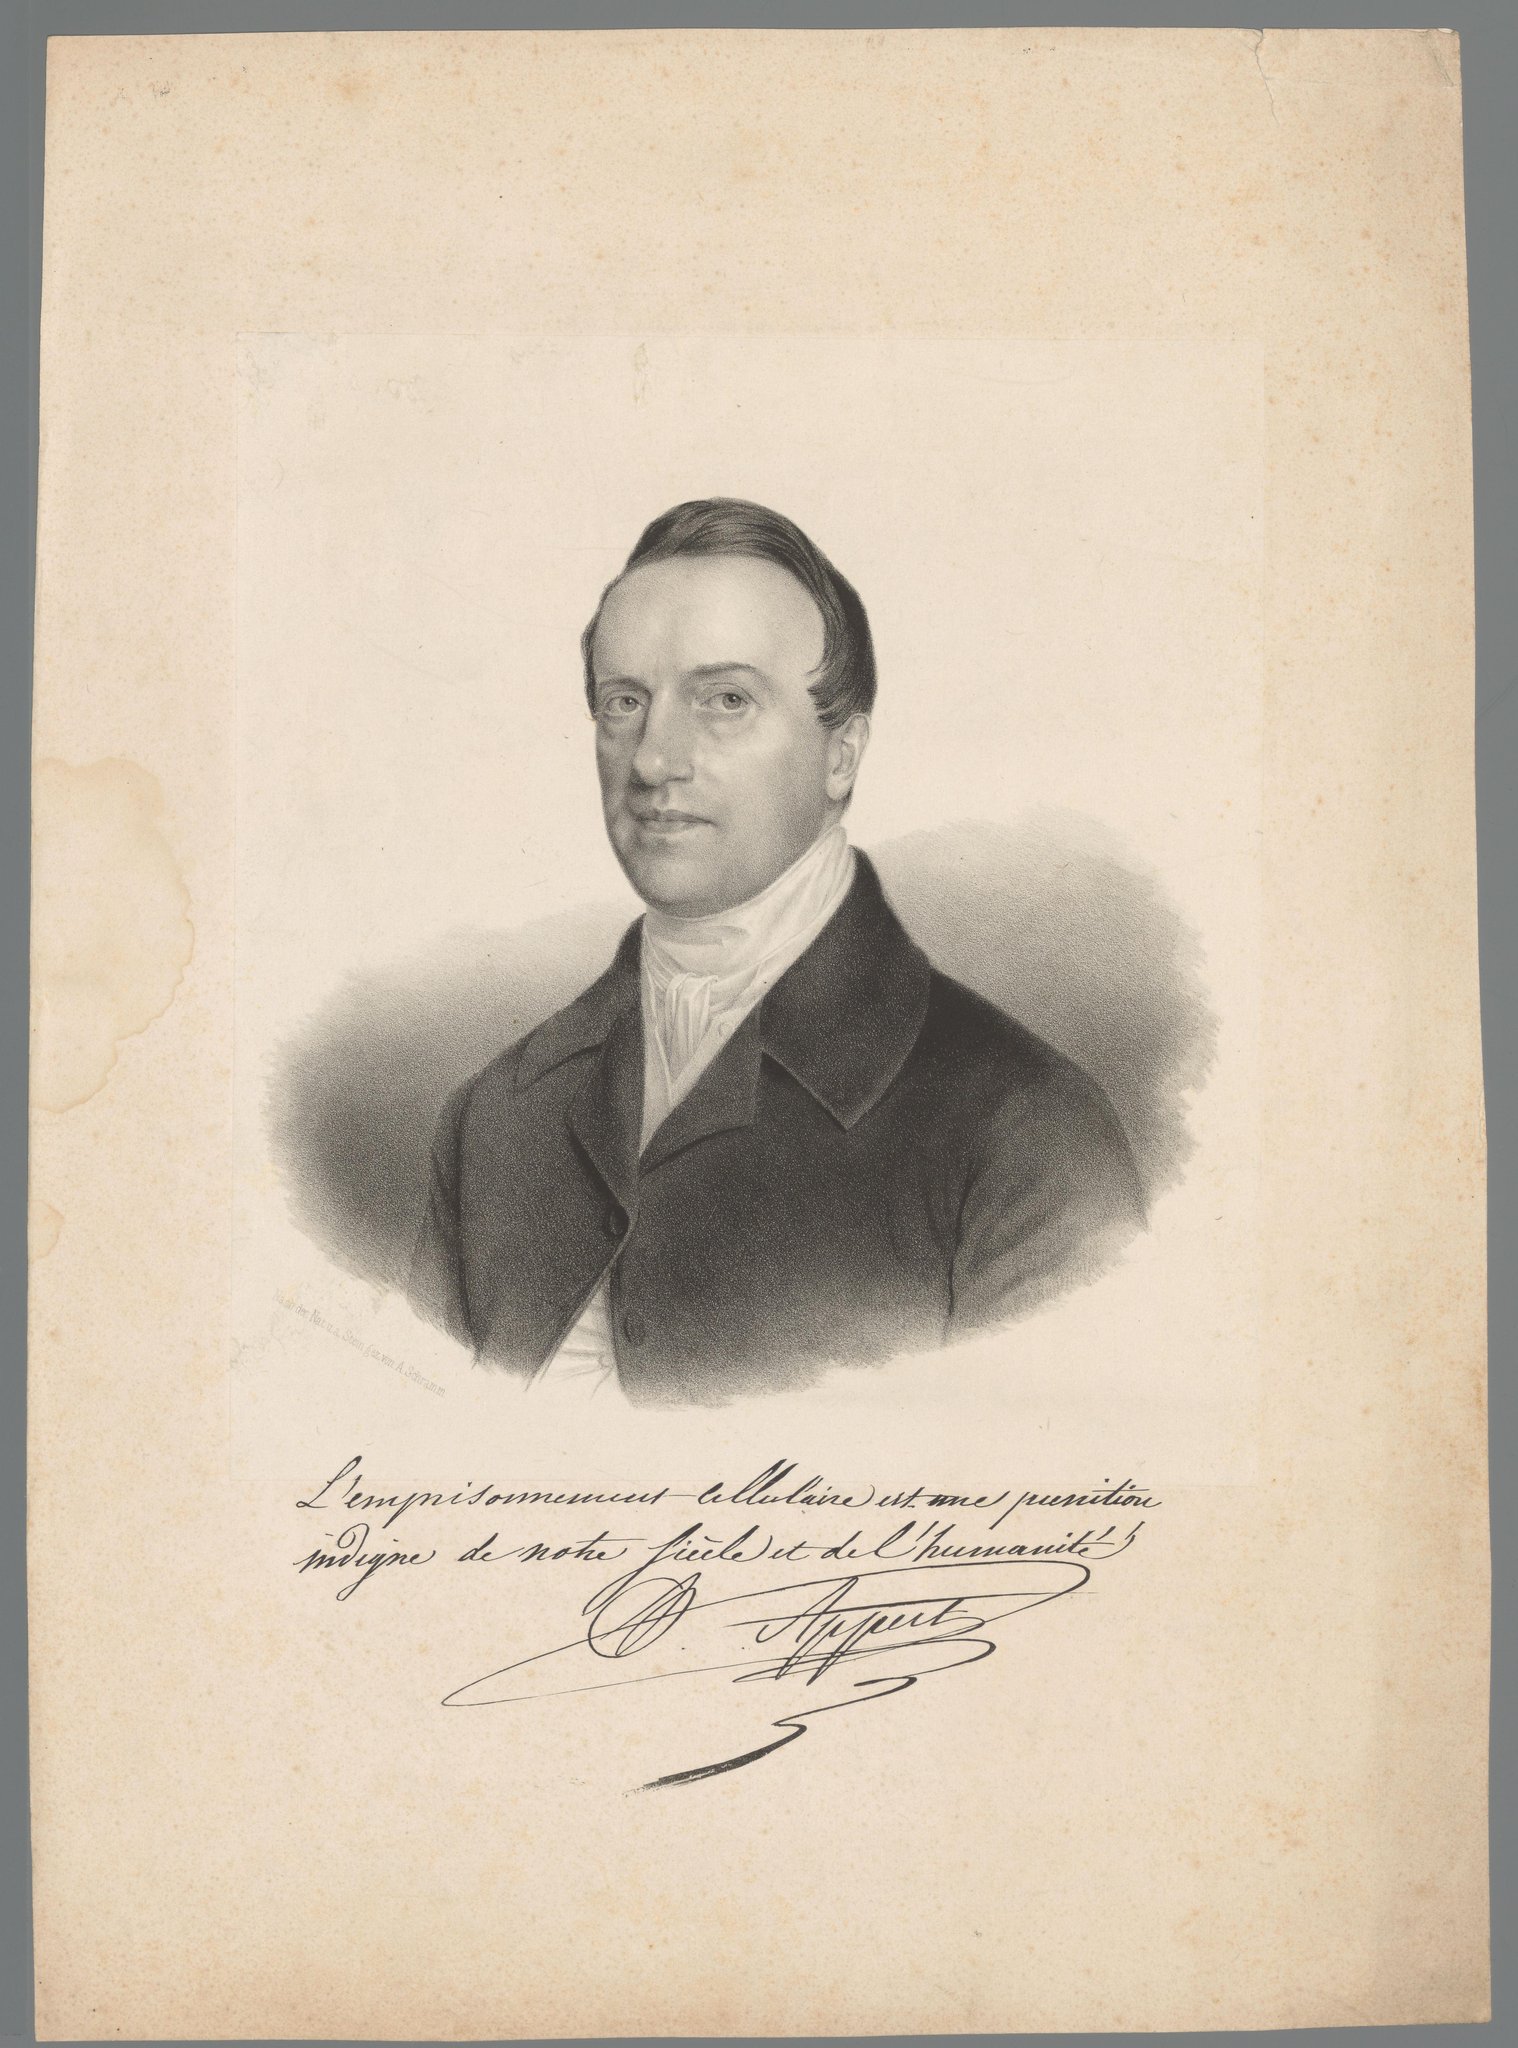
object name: print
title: Portret van O. Apput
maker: alexander schramm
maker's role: painter, print maker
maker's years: 1814-1864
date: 1824-1864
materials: paper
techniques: lithograph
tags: historical persons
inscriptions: collector's mark: Lugt 2228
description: Portret van een verder onbekende man, met handtekening in facsimile waarin mogelijk de naam Apput te lezen is.